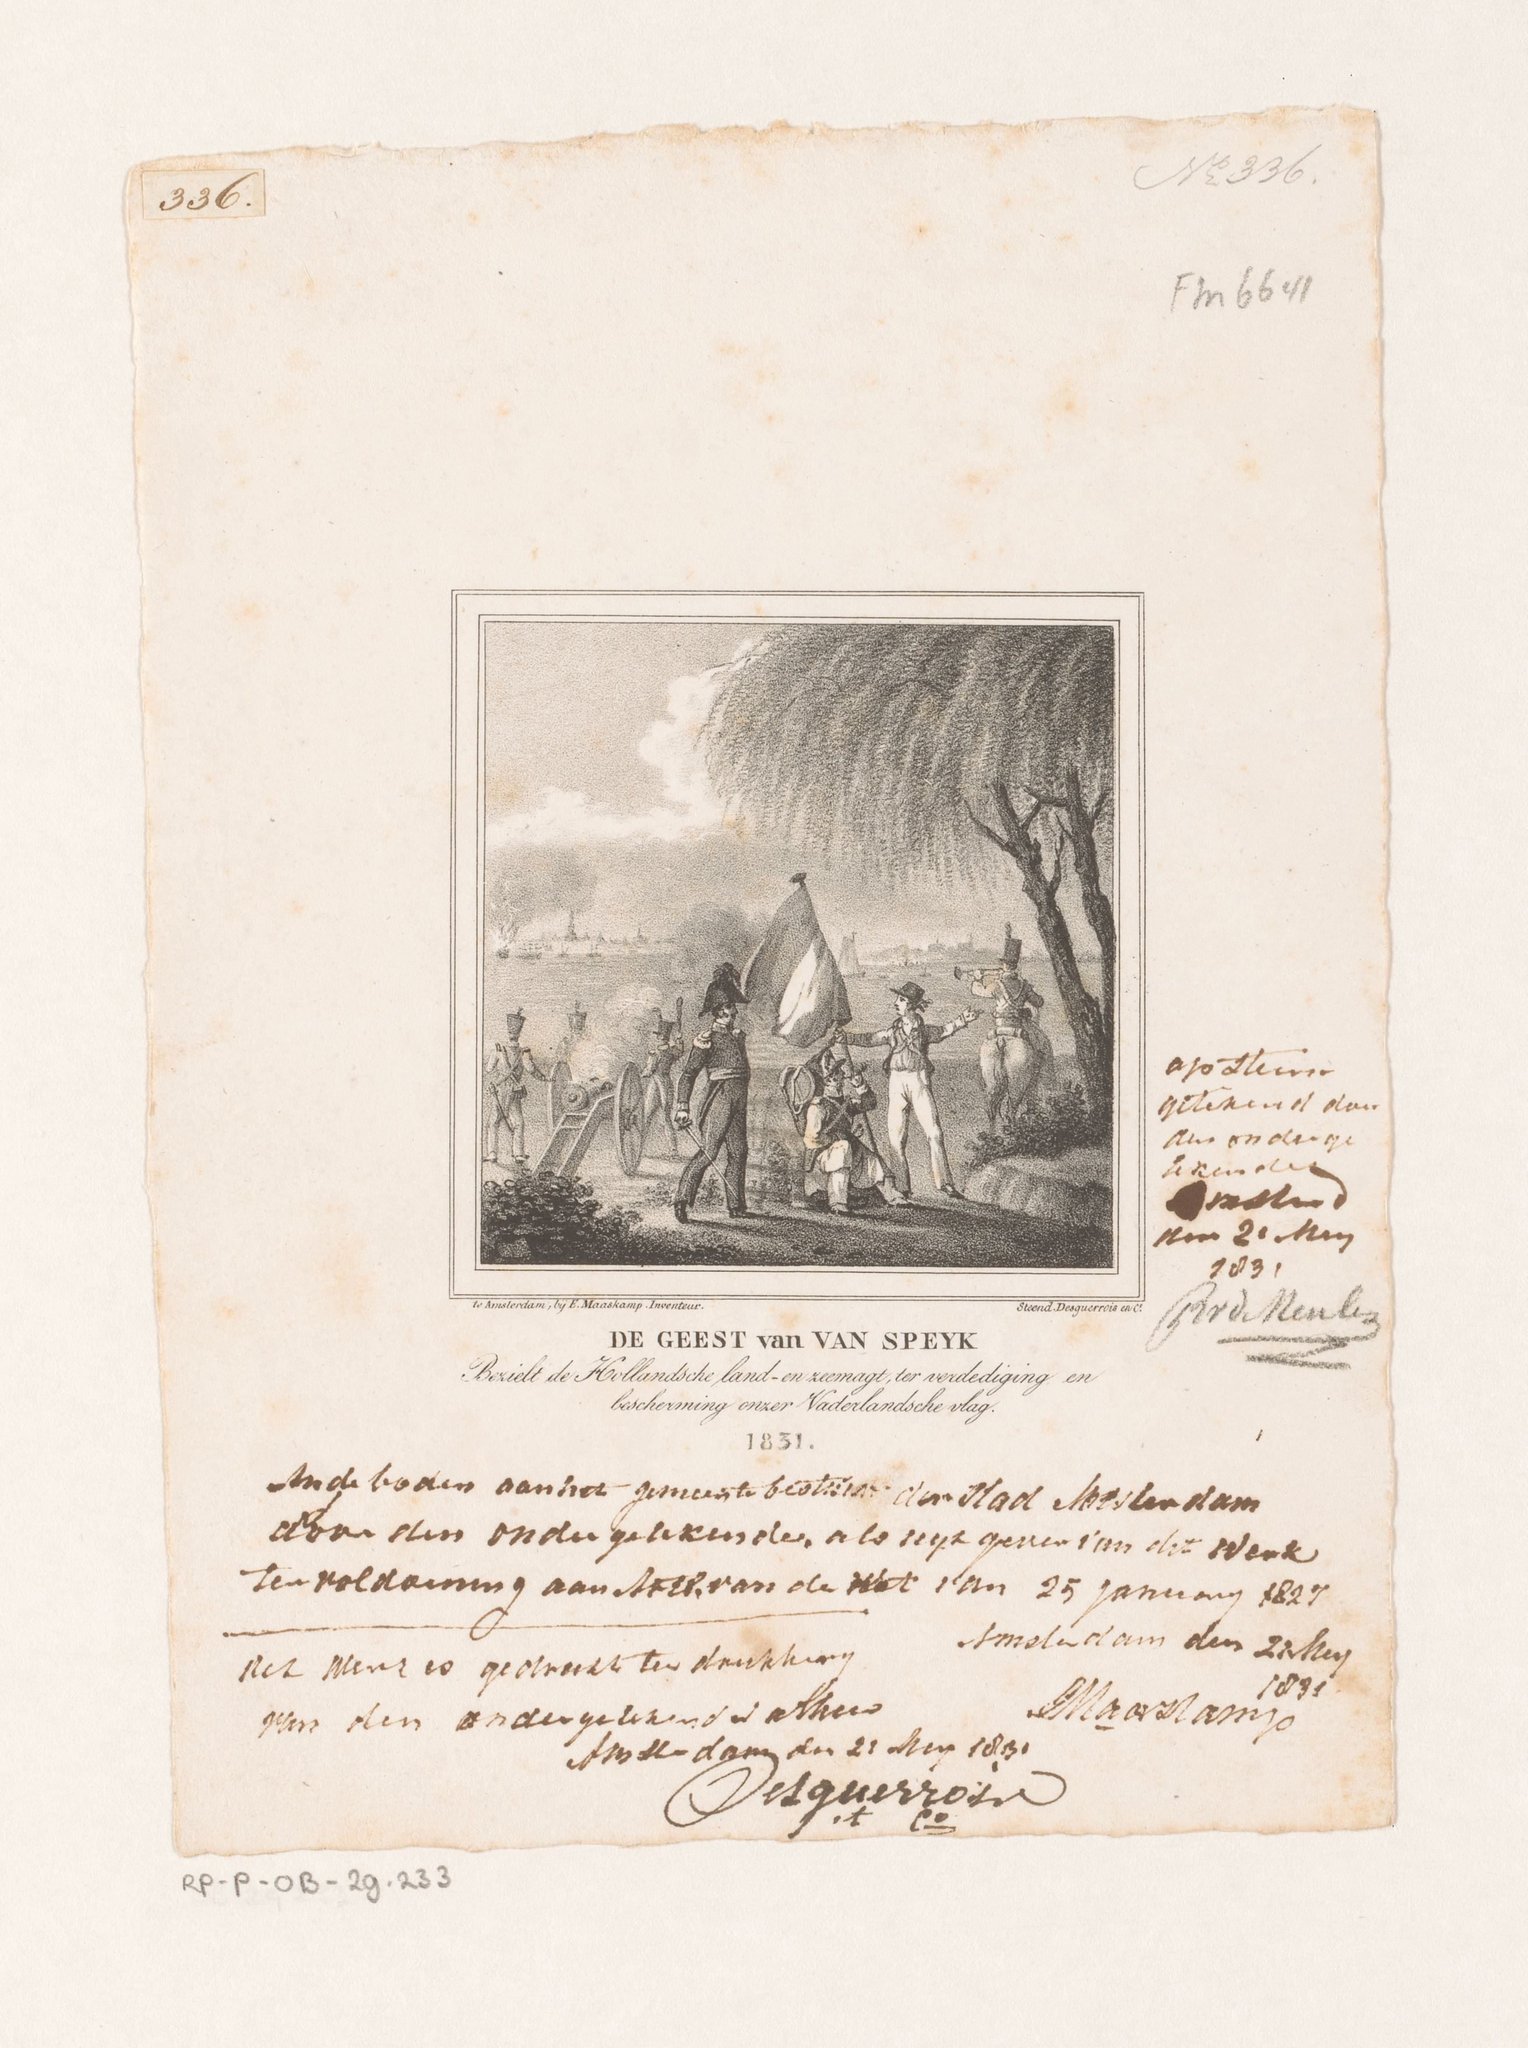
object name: print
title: De geest van Van Speyk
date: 1831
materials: paper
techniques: lithograph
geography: amsterdam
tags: amsterdam, antwerp, jan van speyk, projectiles, explosives, etc.: gunpowder (+ sailing-ships)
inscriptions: : ‘Op steen / getekend door / den onderge / tekende / Amsterdam / den 21 Mey / 1831 / R vd Meulen’, collector's mark: Lugt 2228, : ‘Aangeboden aan het gemeentebestuur der stad Amsterdam / door den ondergetekende, als uitgever van dit werk / ter voldoening aan Art 6. van de Wet van 25 January 1827 / Amsterdam den 21 Mey / 1831 / E Maaskamp’, : ‘Het werk is gedrukt ter drukkerij / van den ondergetekenden alhier / Amsterdam den 21 Mey 1831 / Desguerrois et Co’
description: In de voorgrond een Nederlandse officier, matroos en infanteris. Zij staan zodanig gegroepeerd dat tussen hen in de geest van Van Speyk zichtbaar wordt. Verderop het slagveld. Aan de horizon ligt Antwerpen, links ontploft de kanonneerboot van Van Speyk.